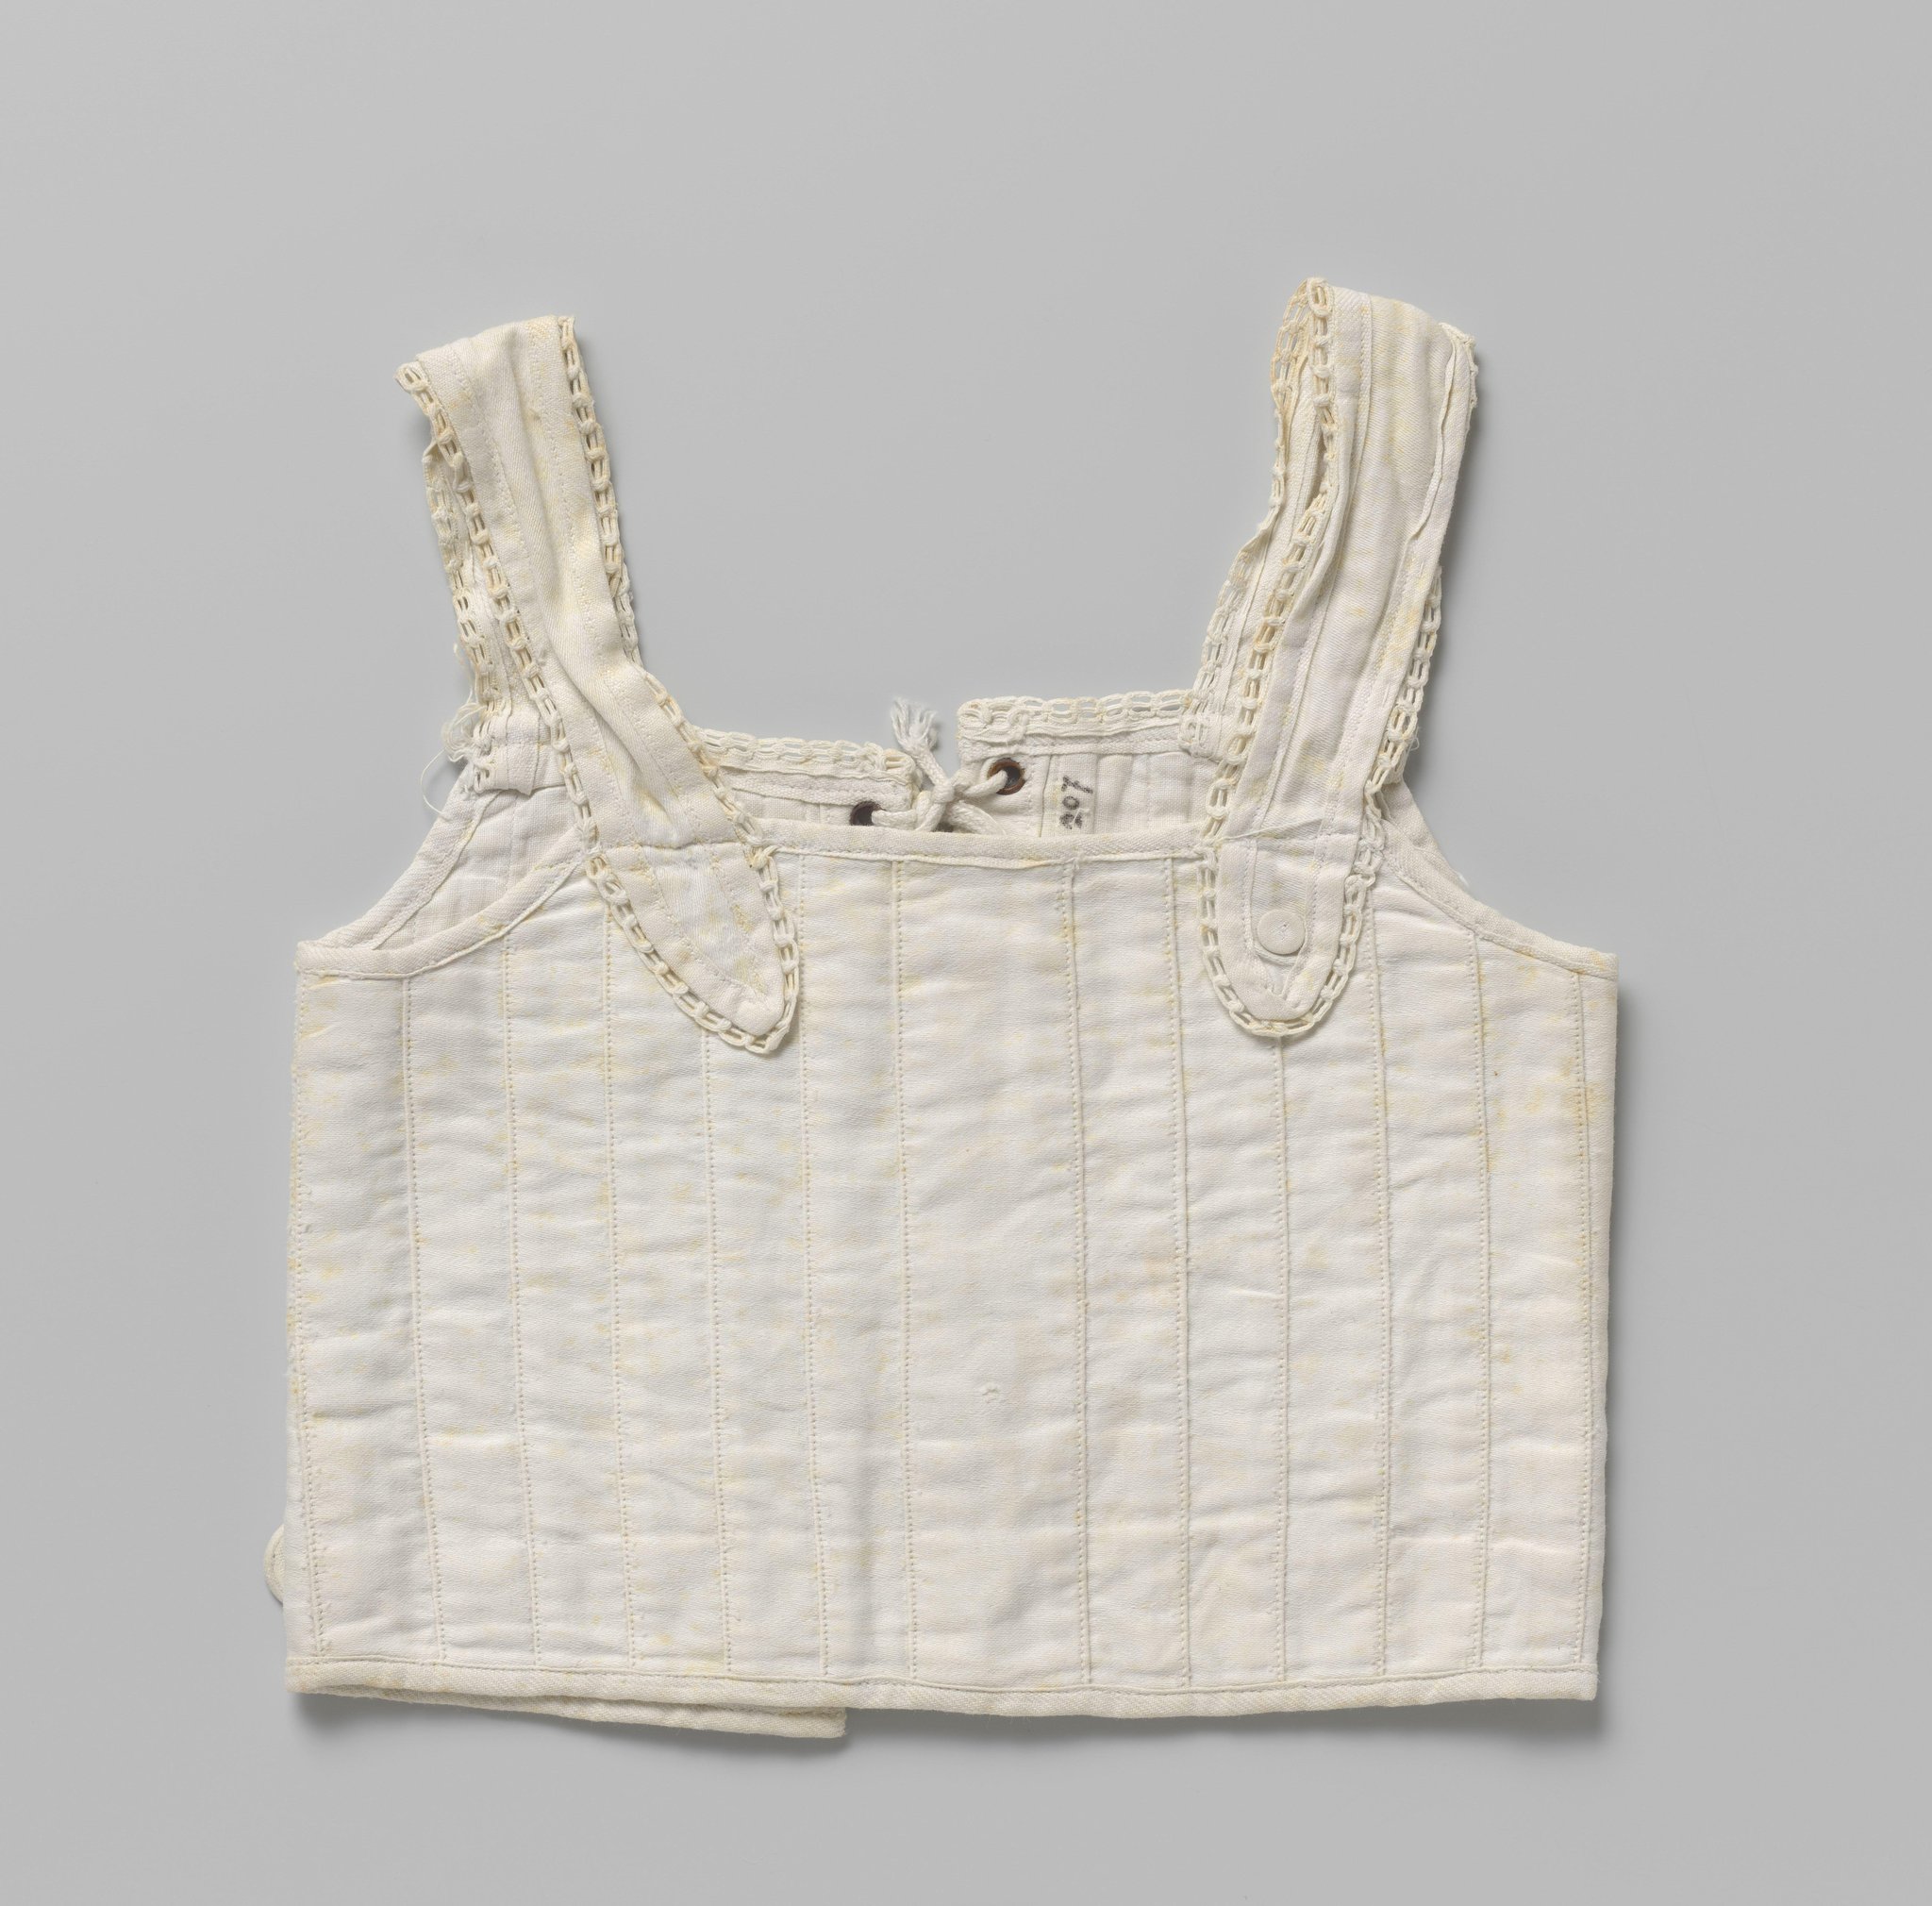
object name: childrenswear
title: Lijf van wit katoen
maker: Anonymous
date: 1890-1900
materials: cotton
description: Lijf van wit katoen met satijnbinding met verticale oprijgen, vetersluiting en twee knopen; langs de hals en schouderbanden een opengewerkte rand.